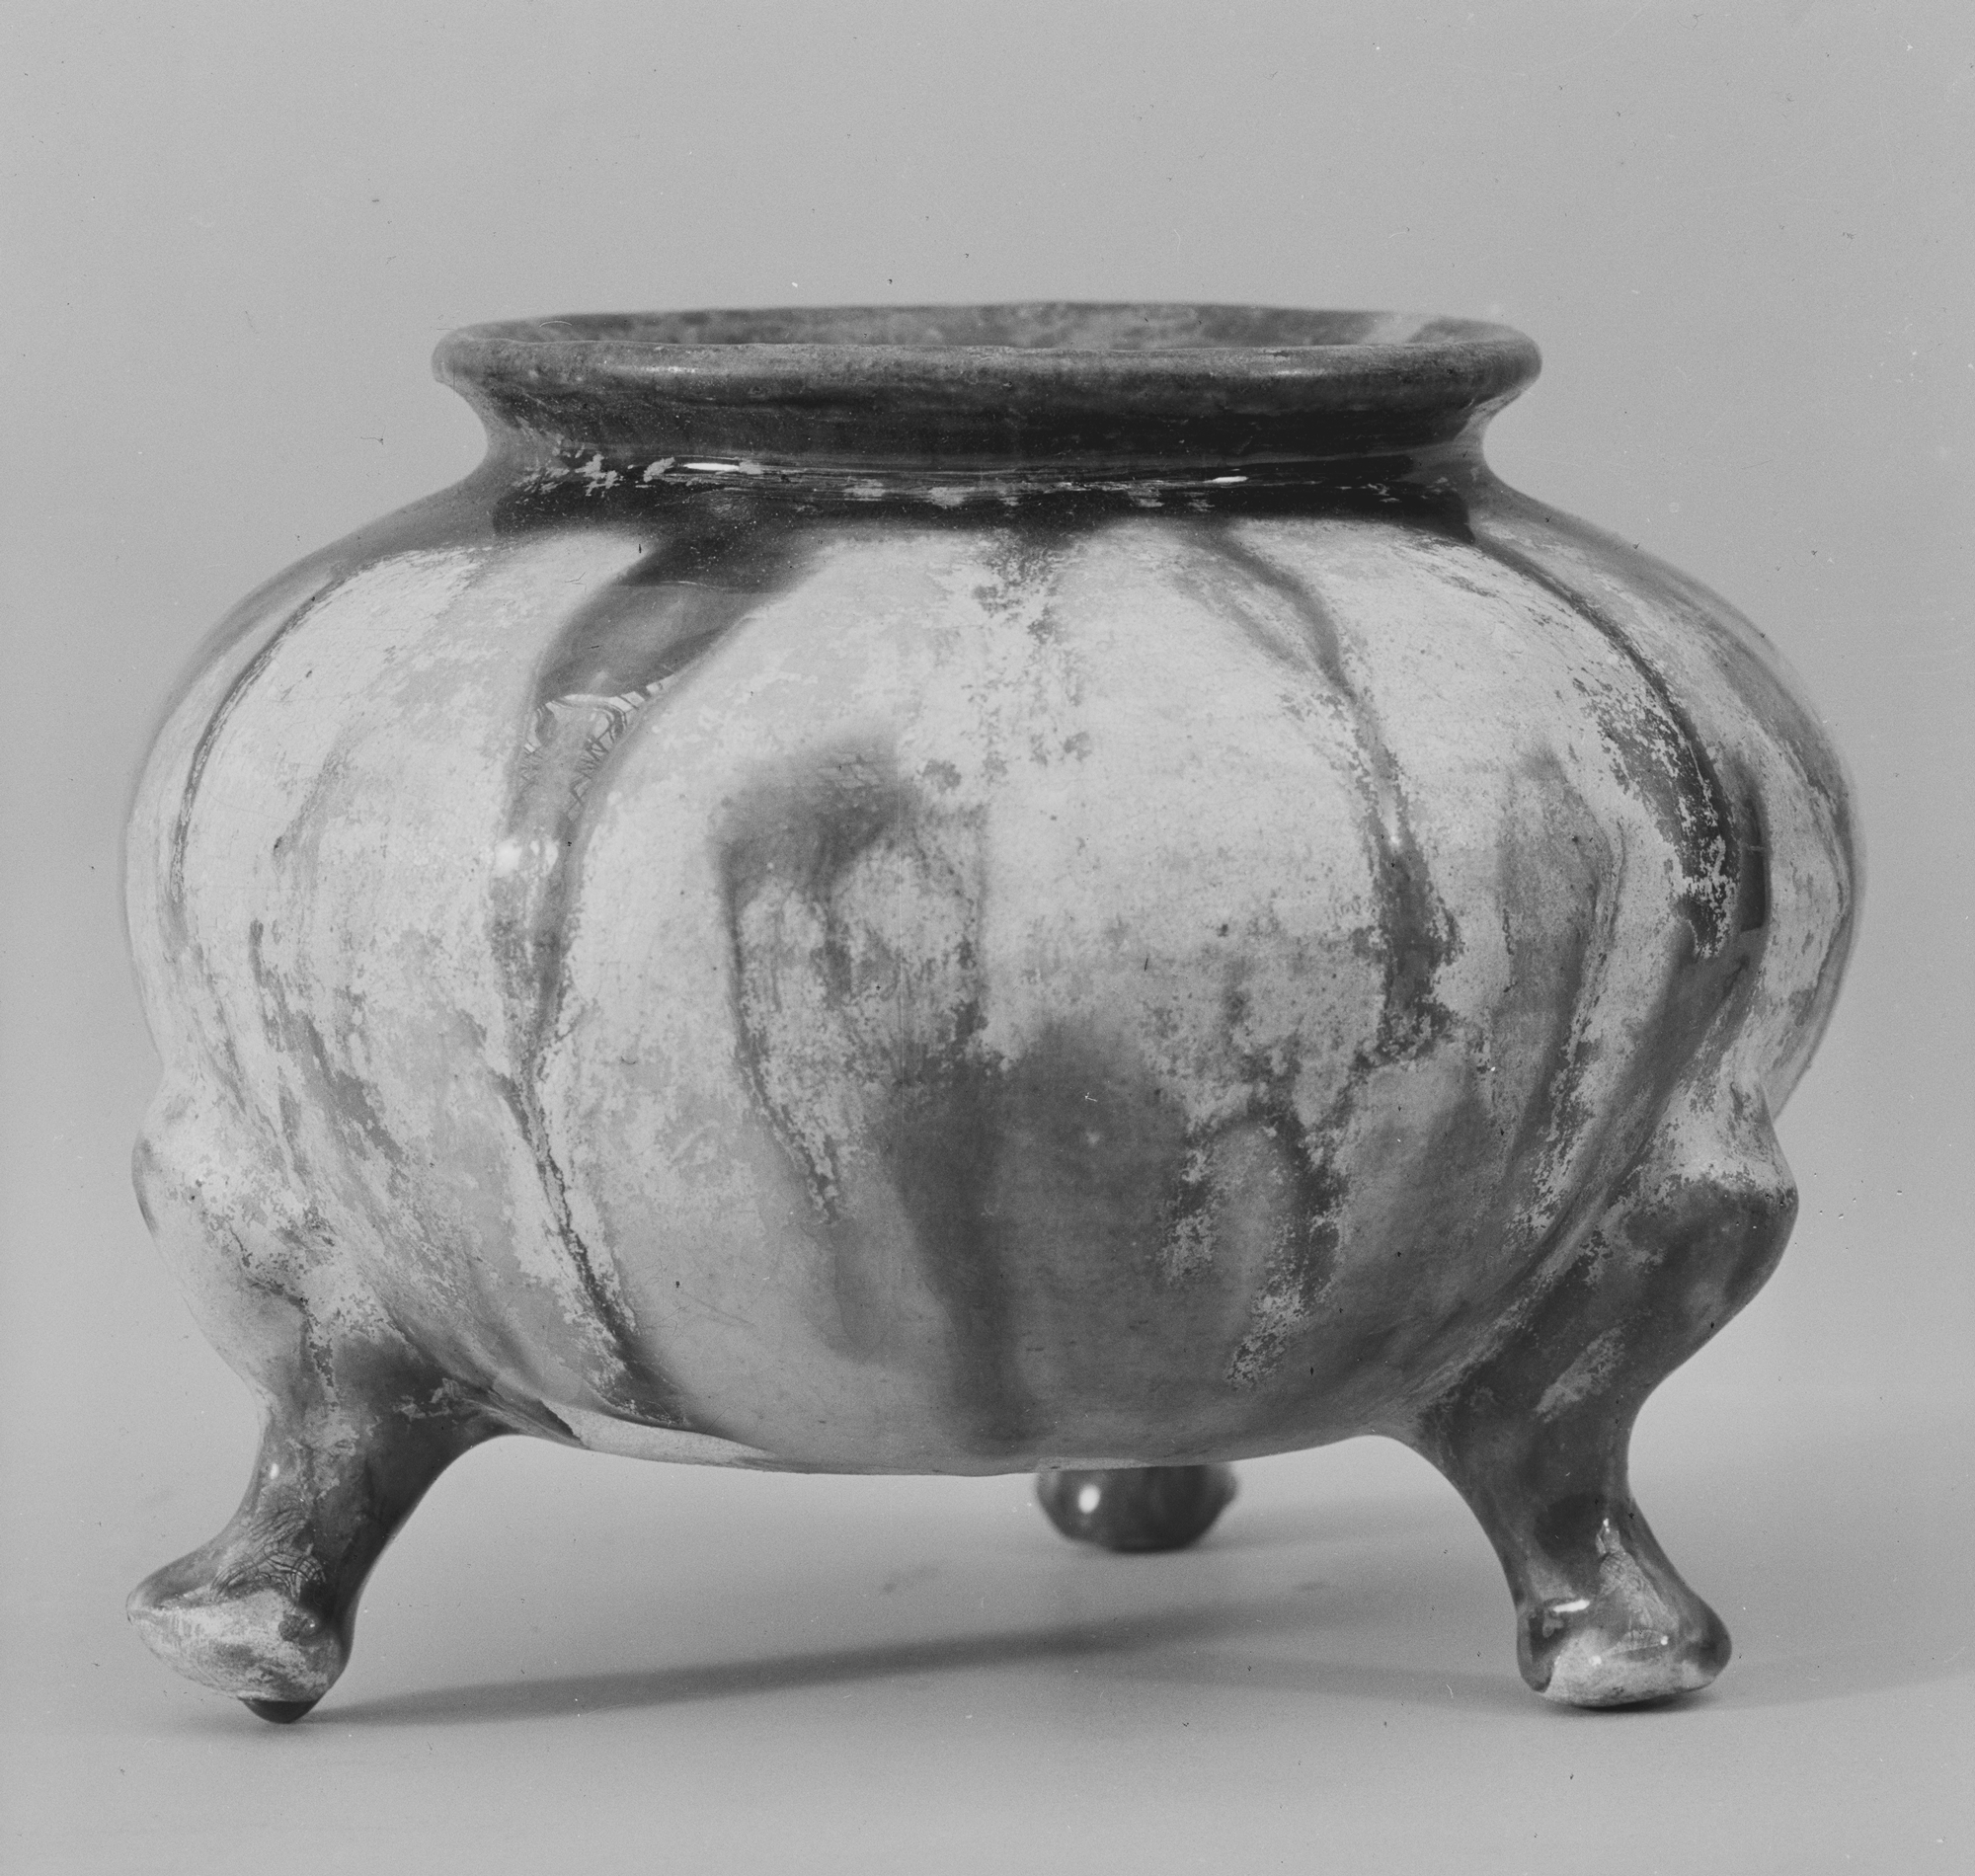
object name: vase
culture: chinese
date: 1901-2000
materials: pottery